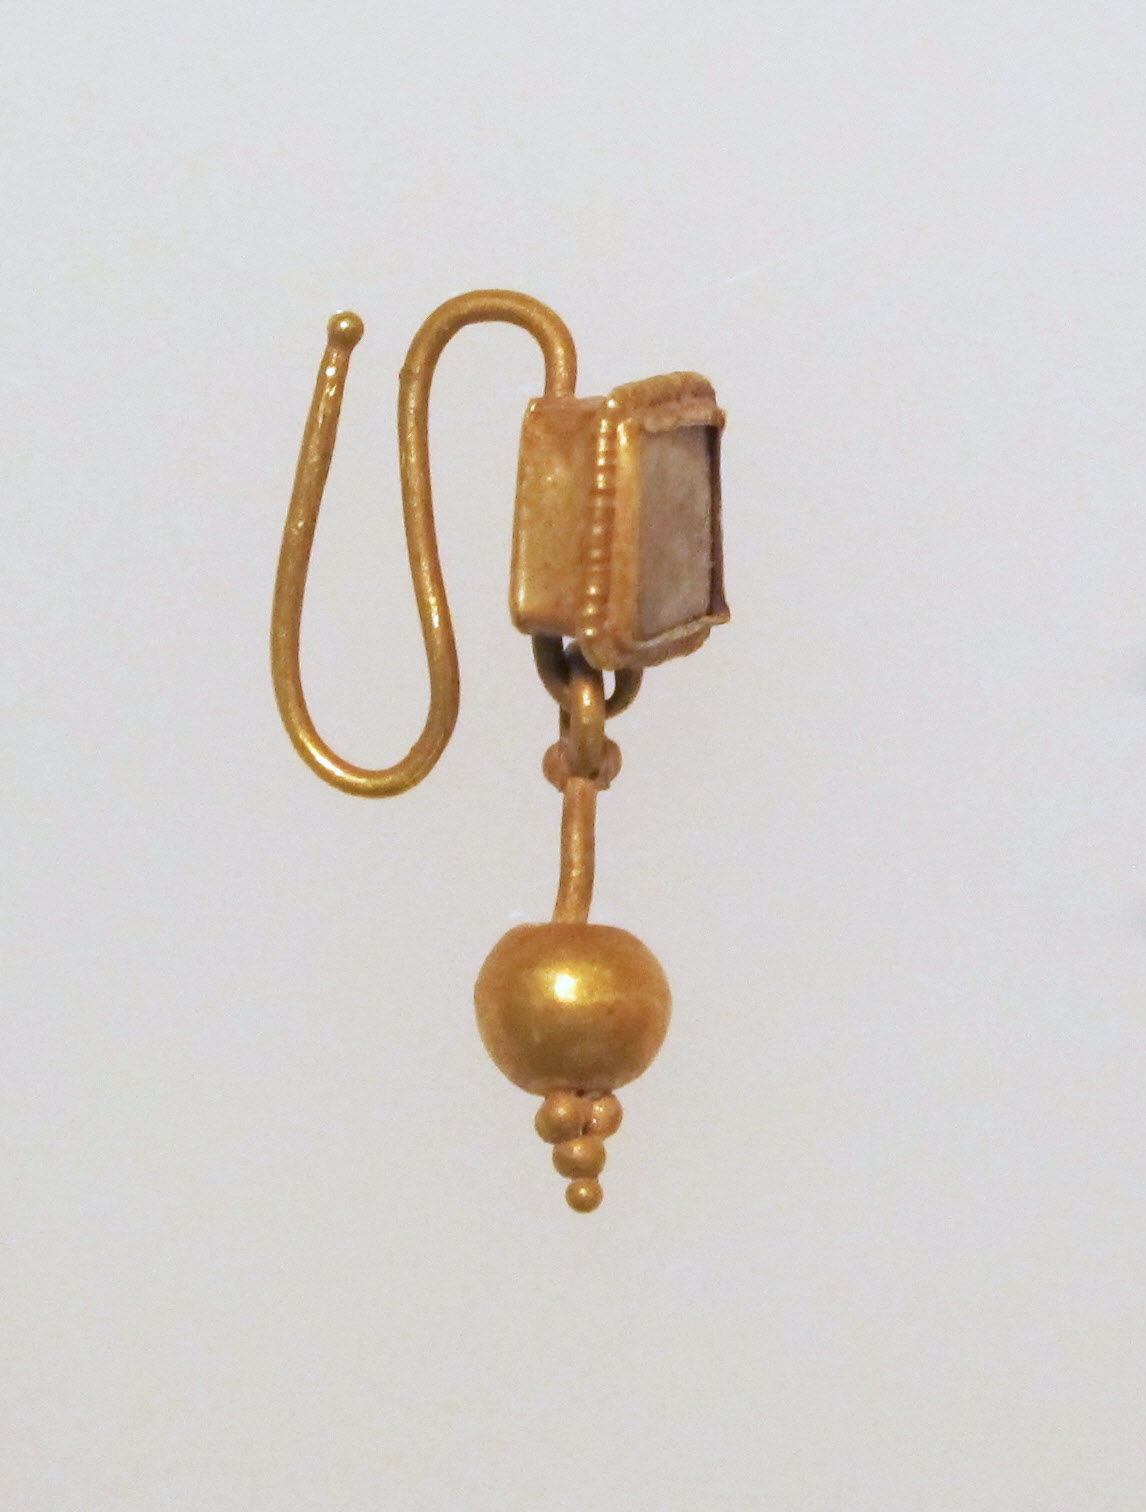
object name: earring hook type with ball pendant and paste setting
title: Earring-hook type with ball pendant and paste setting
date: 7000 BCE-330 CE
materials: glass, gold, paste